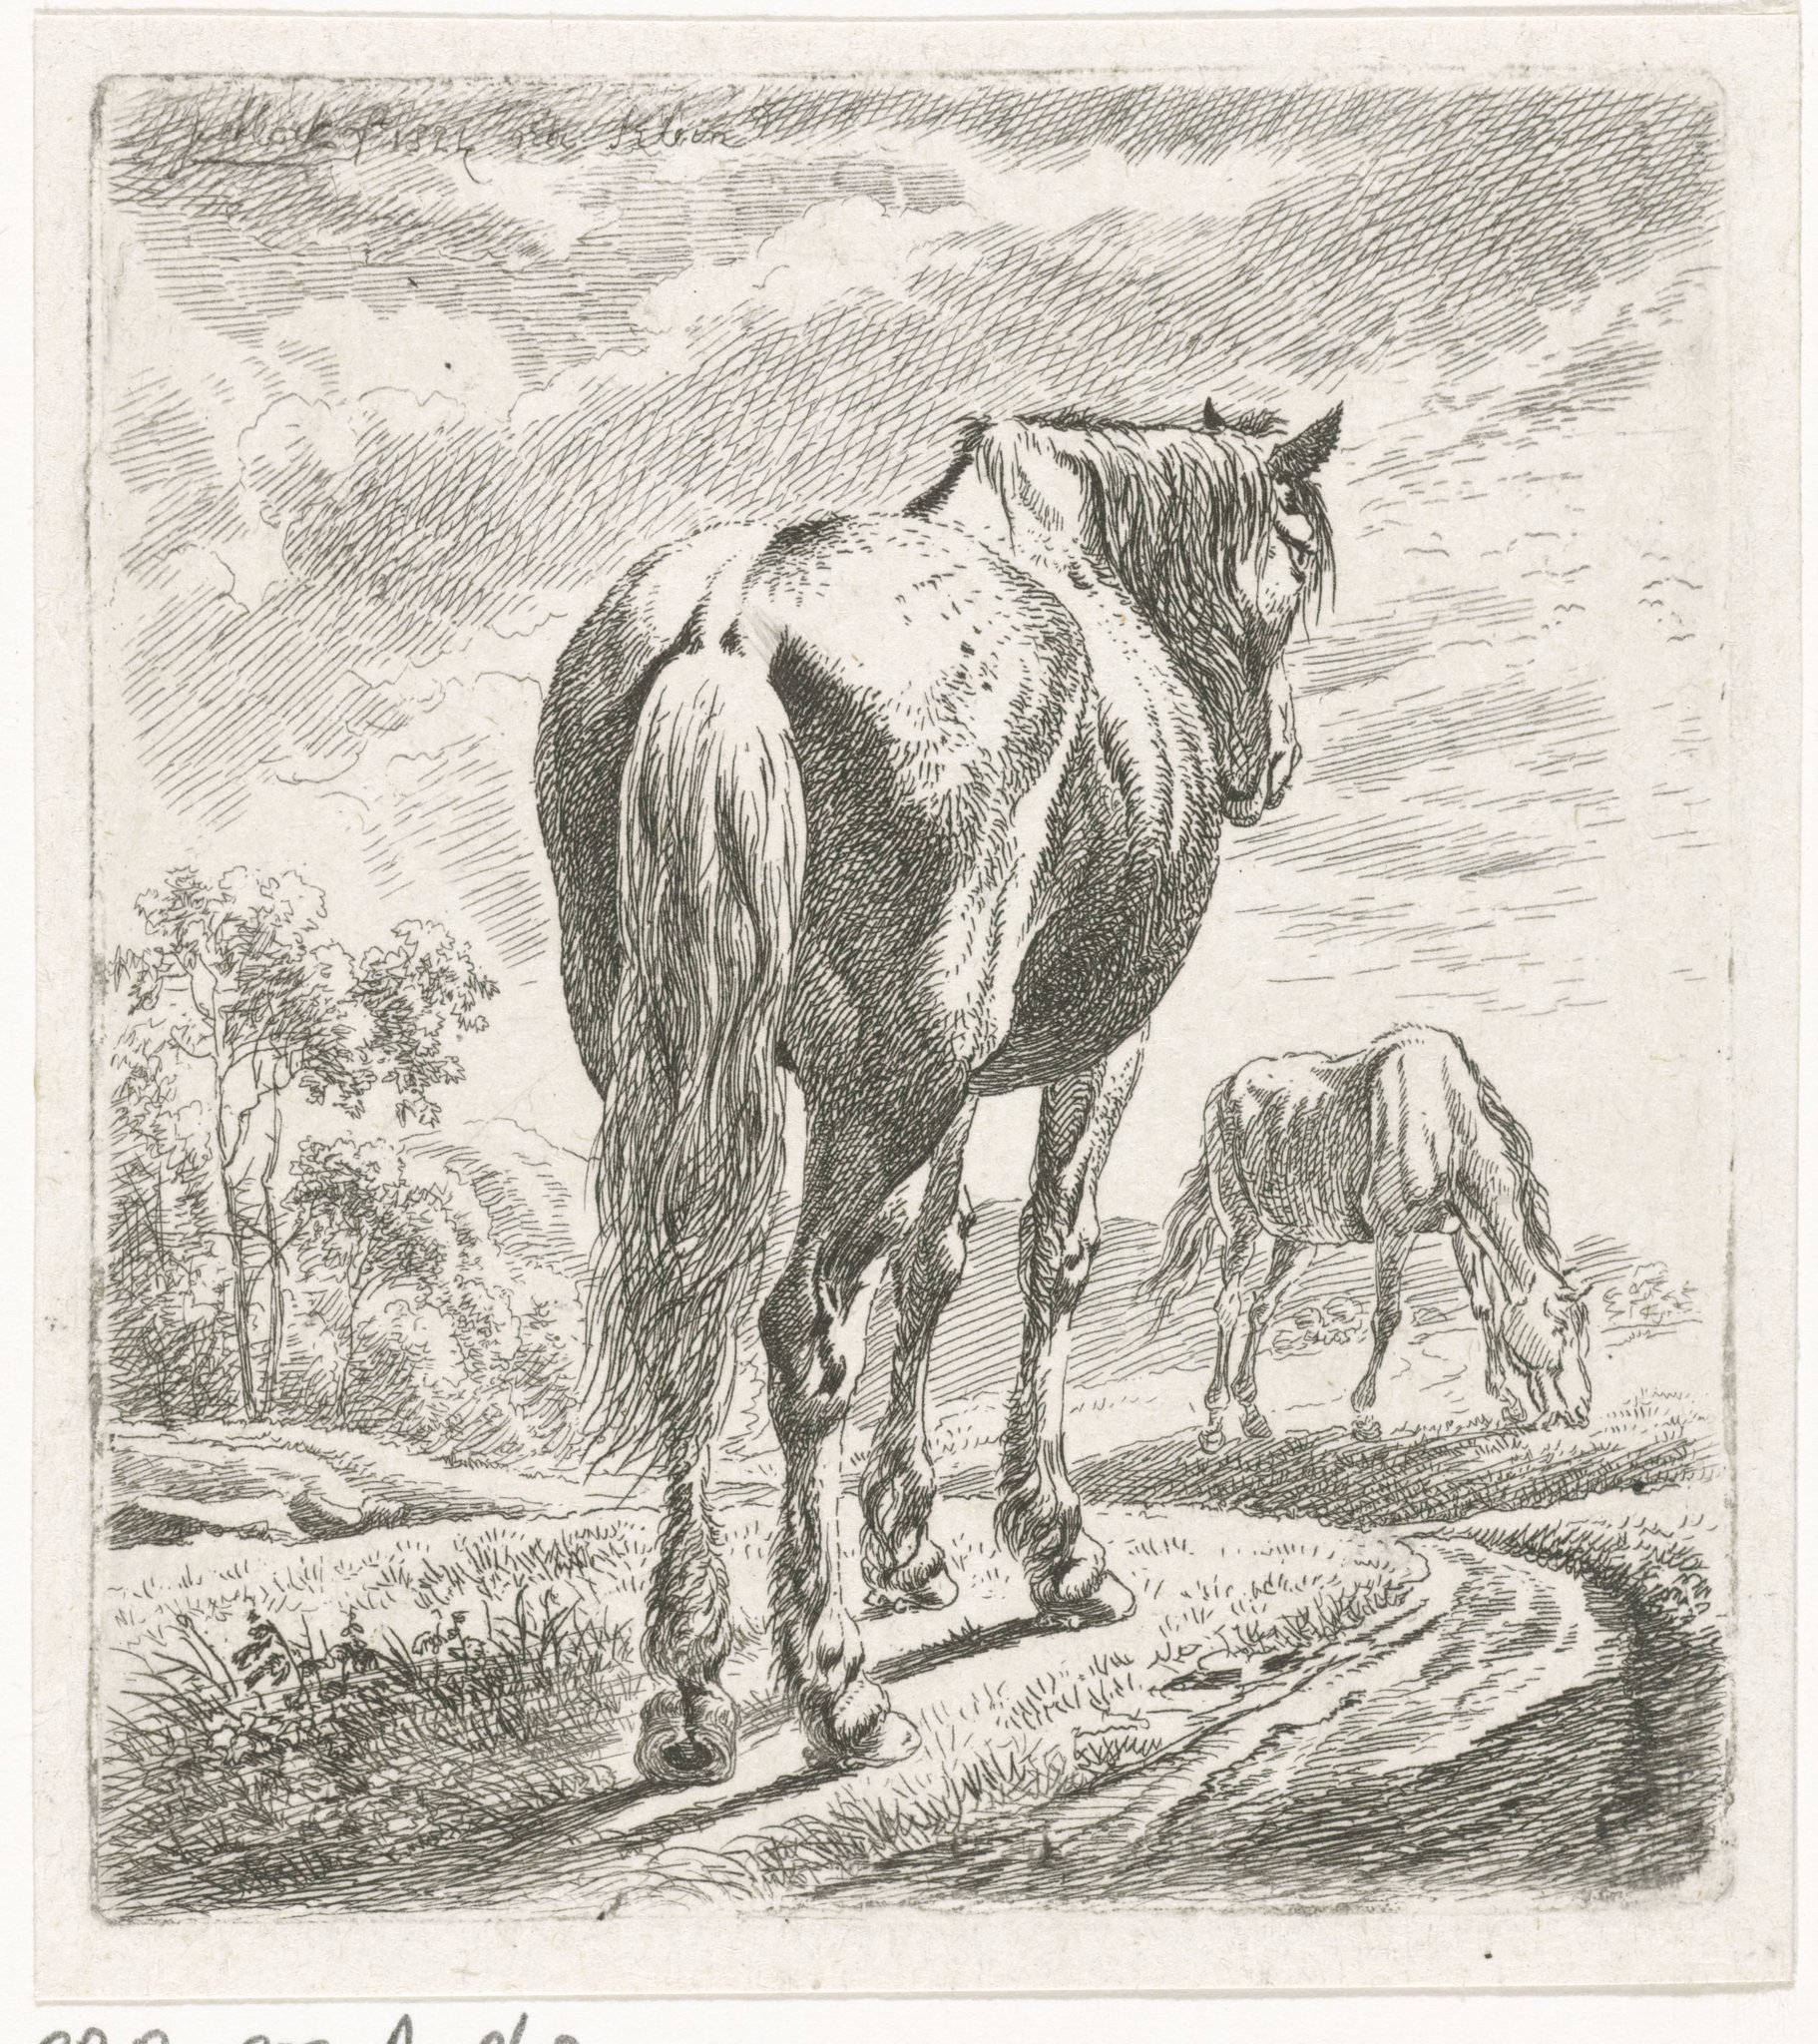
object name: print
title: Paard van achteren gezien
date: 1824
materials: paper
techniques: etching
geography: netherlands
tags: horses and kindred animals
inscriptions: collector's mark: Lugt 2228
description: Een paard schuin van achteren gezien. Op de achtergrond een grazend paard.